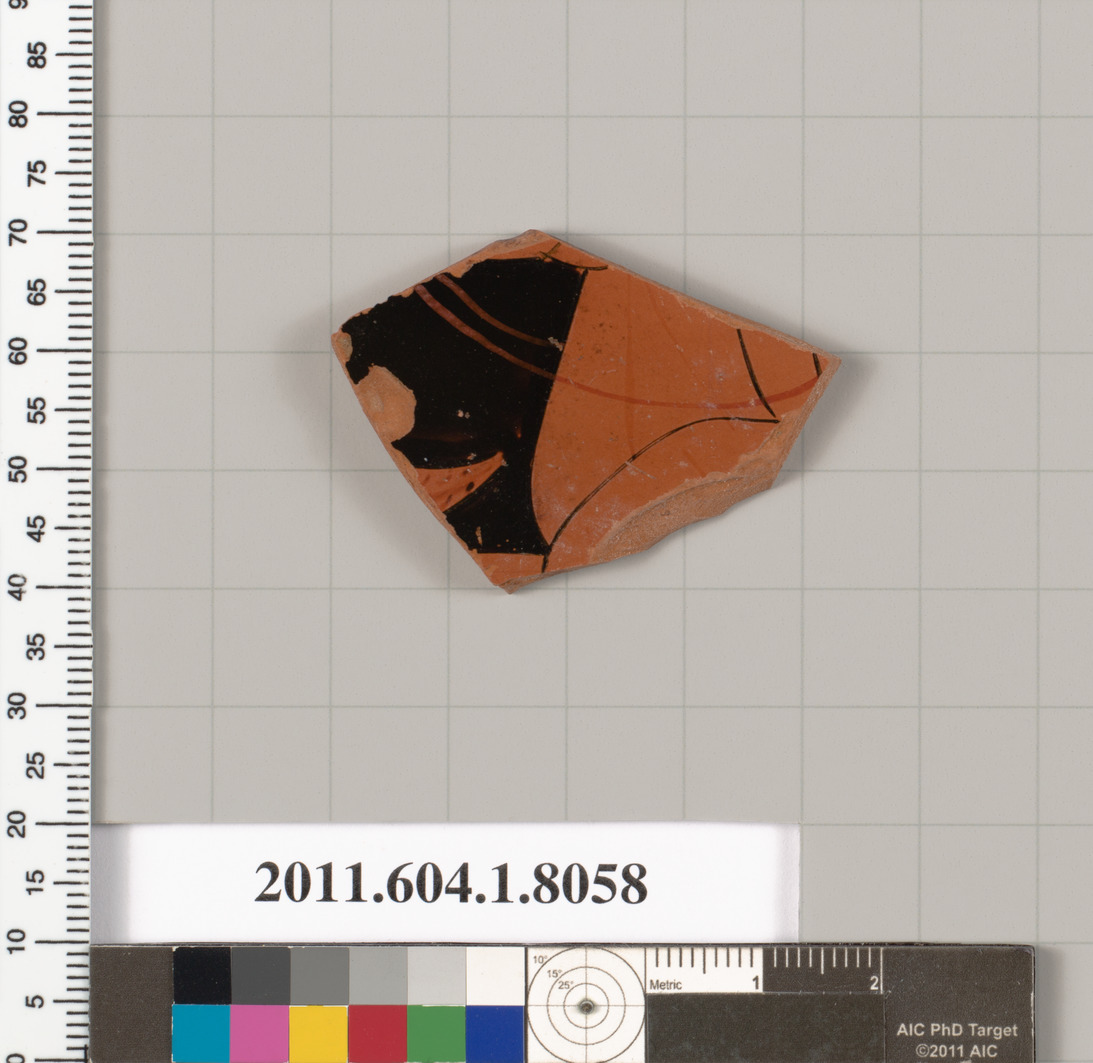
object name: kylix fragment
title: Terracotta fragment of a kylix (drinking cup)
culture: greek, attic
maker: euergides painter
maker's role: artist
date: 510-500 BCE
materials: terracotta